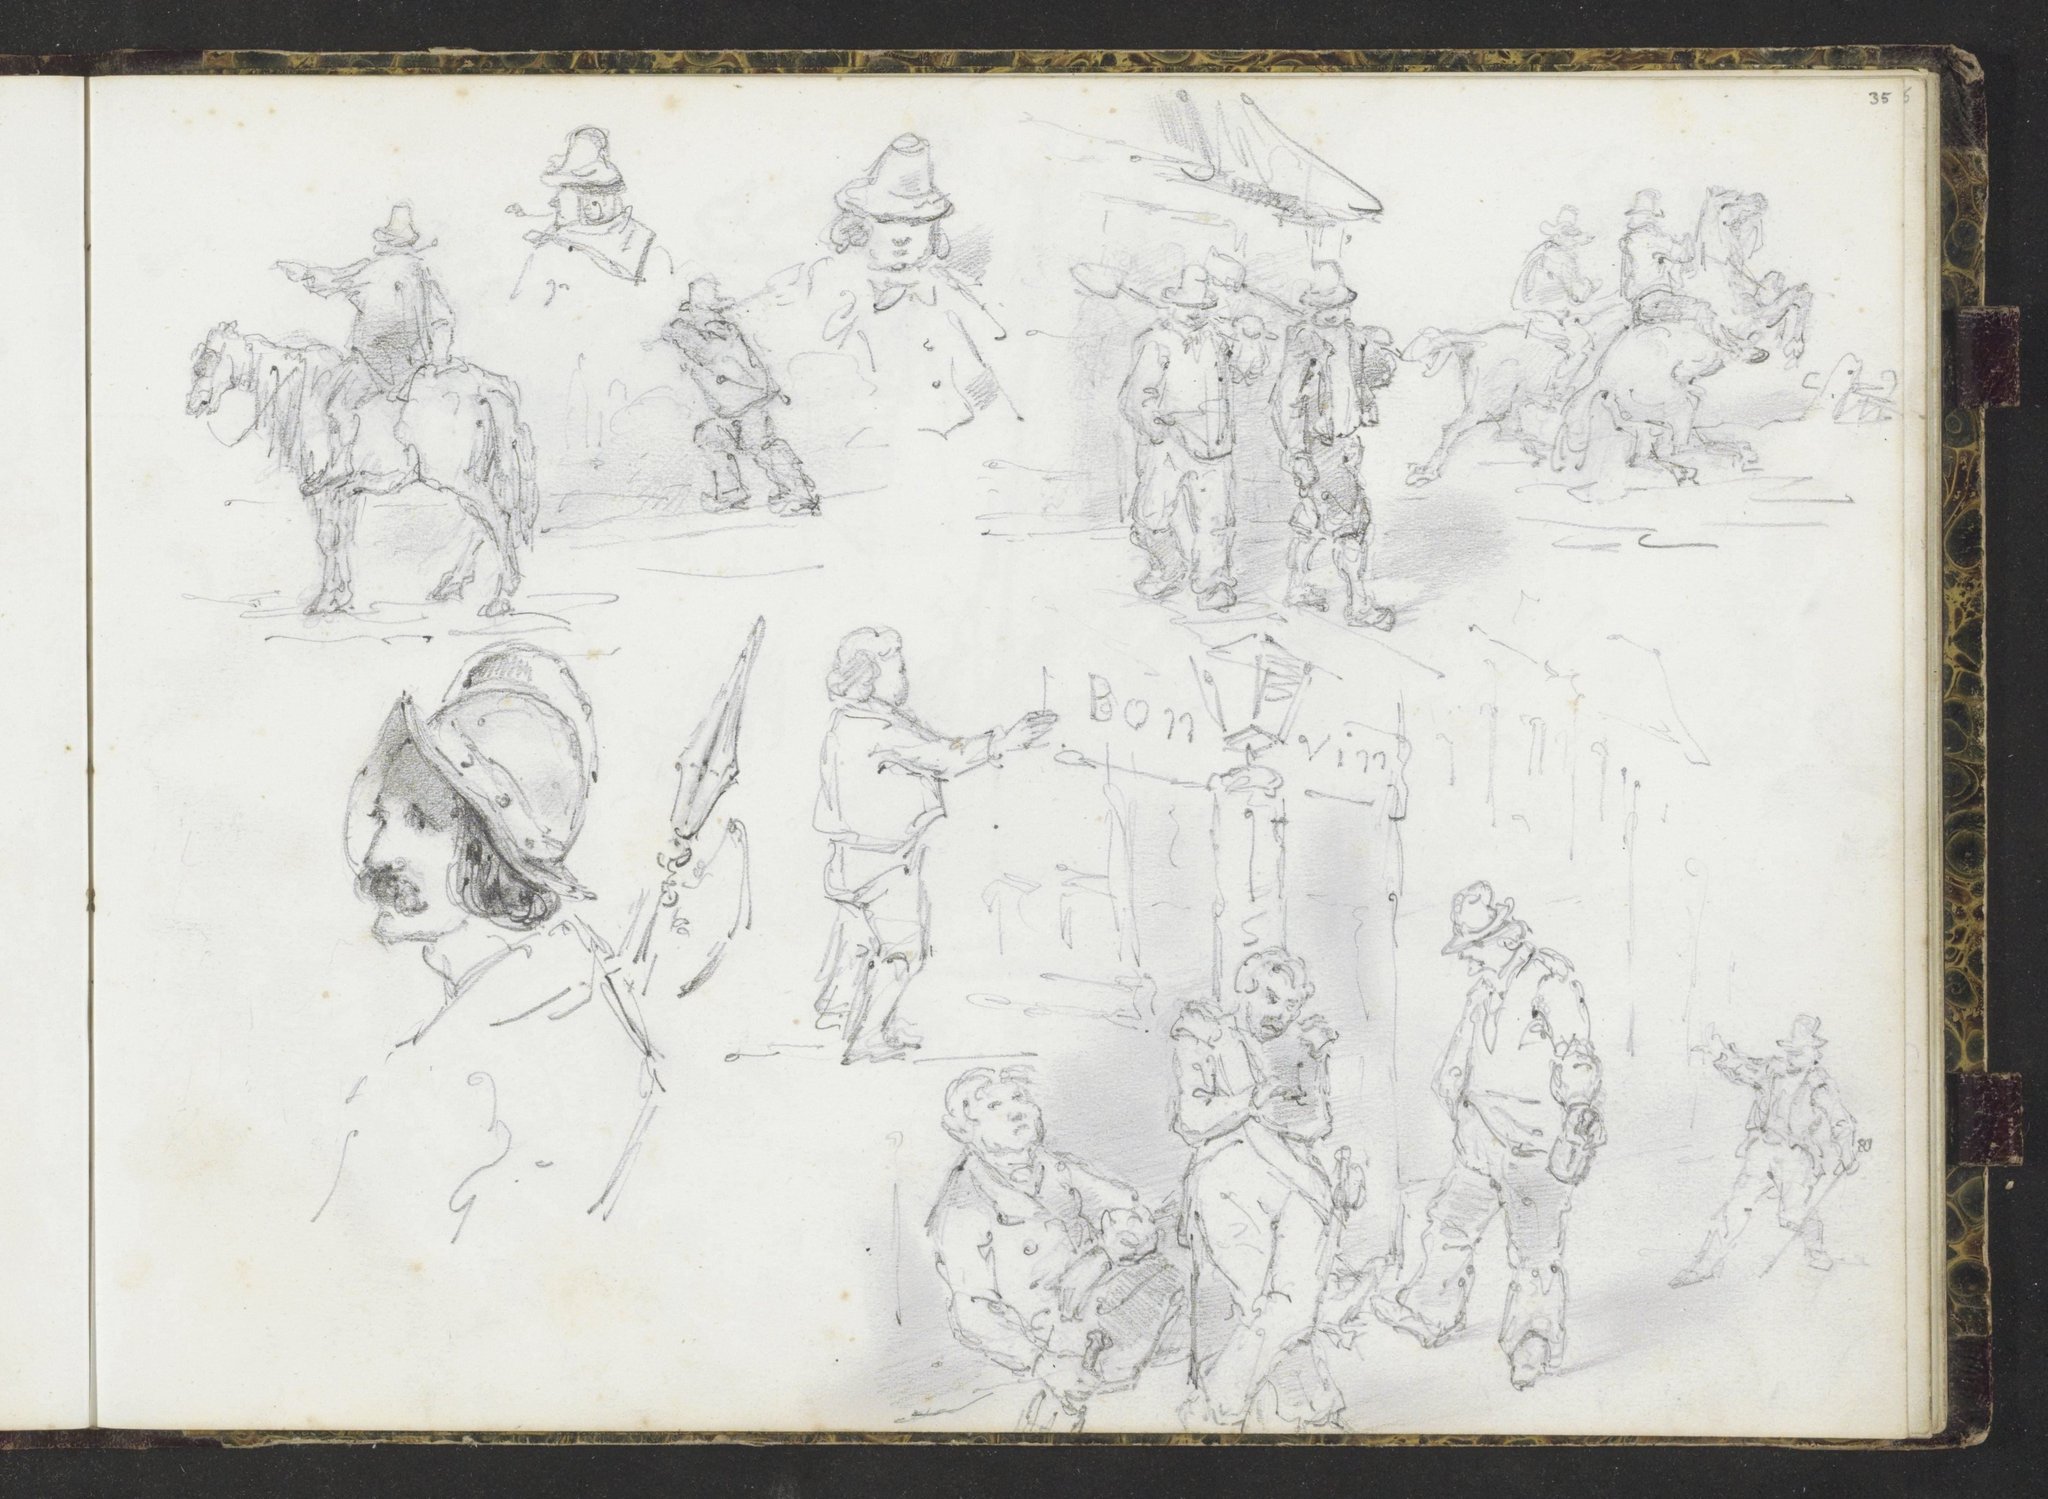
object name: sketchbook leaf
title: Studieblad met mannen voor een café, een ruiter en soldaat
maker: lambertus lingeman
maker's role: draughtsman, painter, print maker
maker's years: 1829-1894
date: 1839-1894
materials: paper, pencil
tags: riding a horse, ass, or mule; rider, horseman, the soldier; the soldier's life, street (+ city(-scape) with figures, staffage)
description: Tevens studies van figuren en een straatscène met arbeiders die schoppen op de schouder dragen. Blad 35 recto uit een schetsboek met 51 bladen.